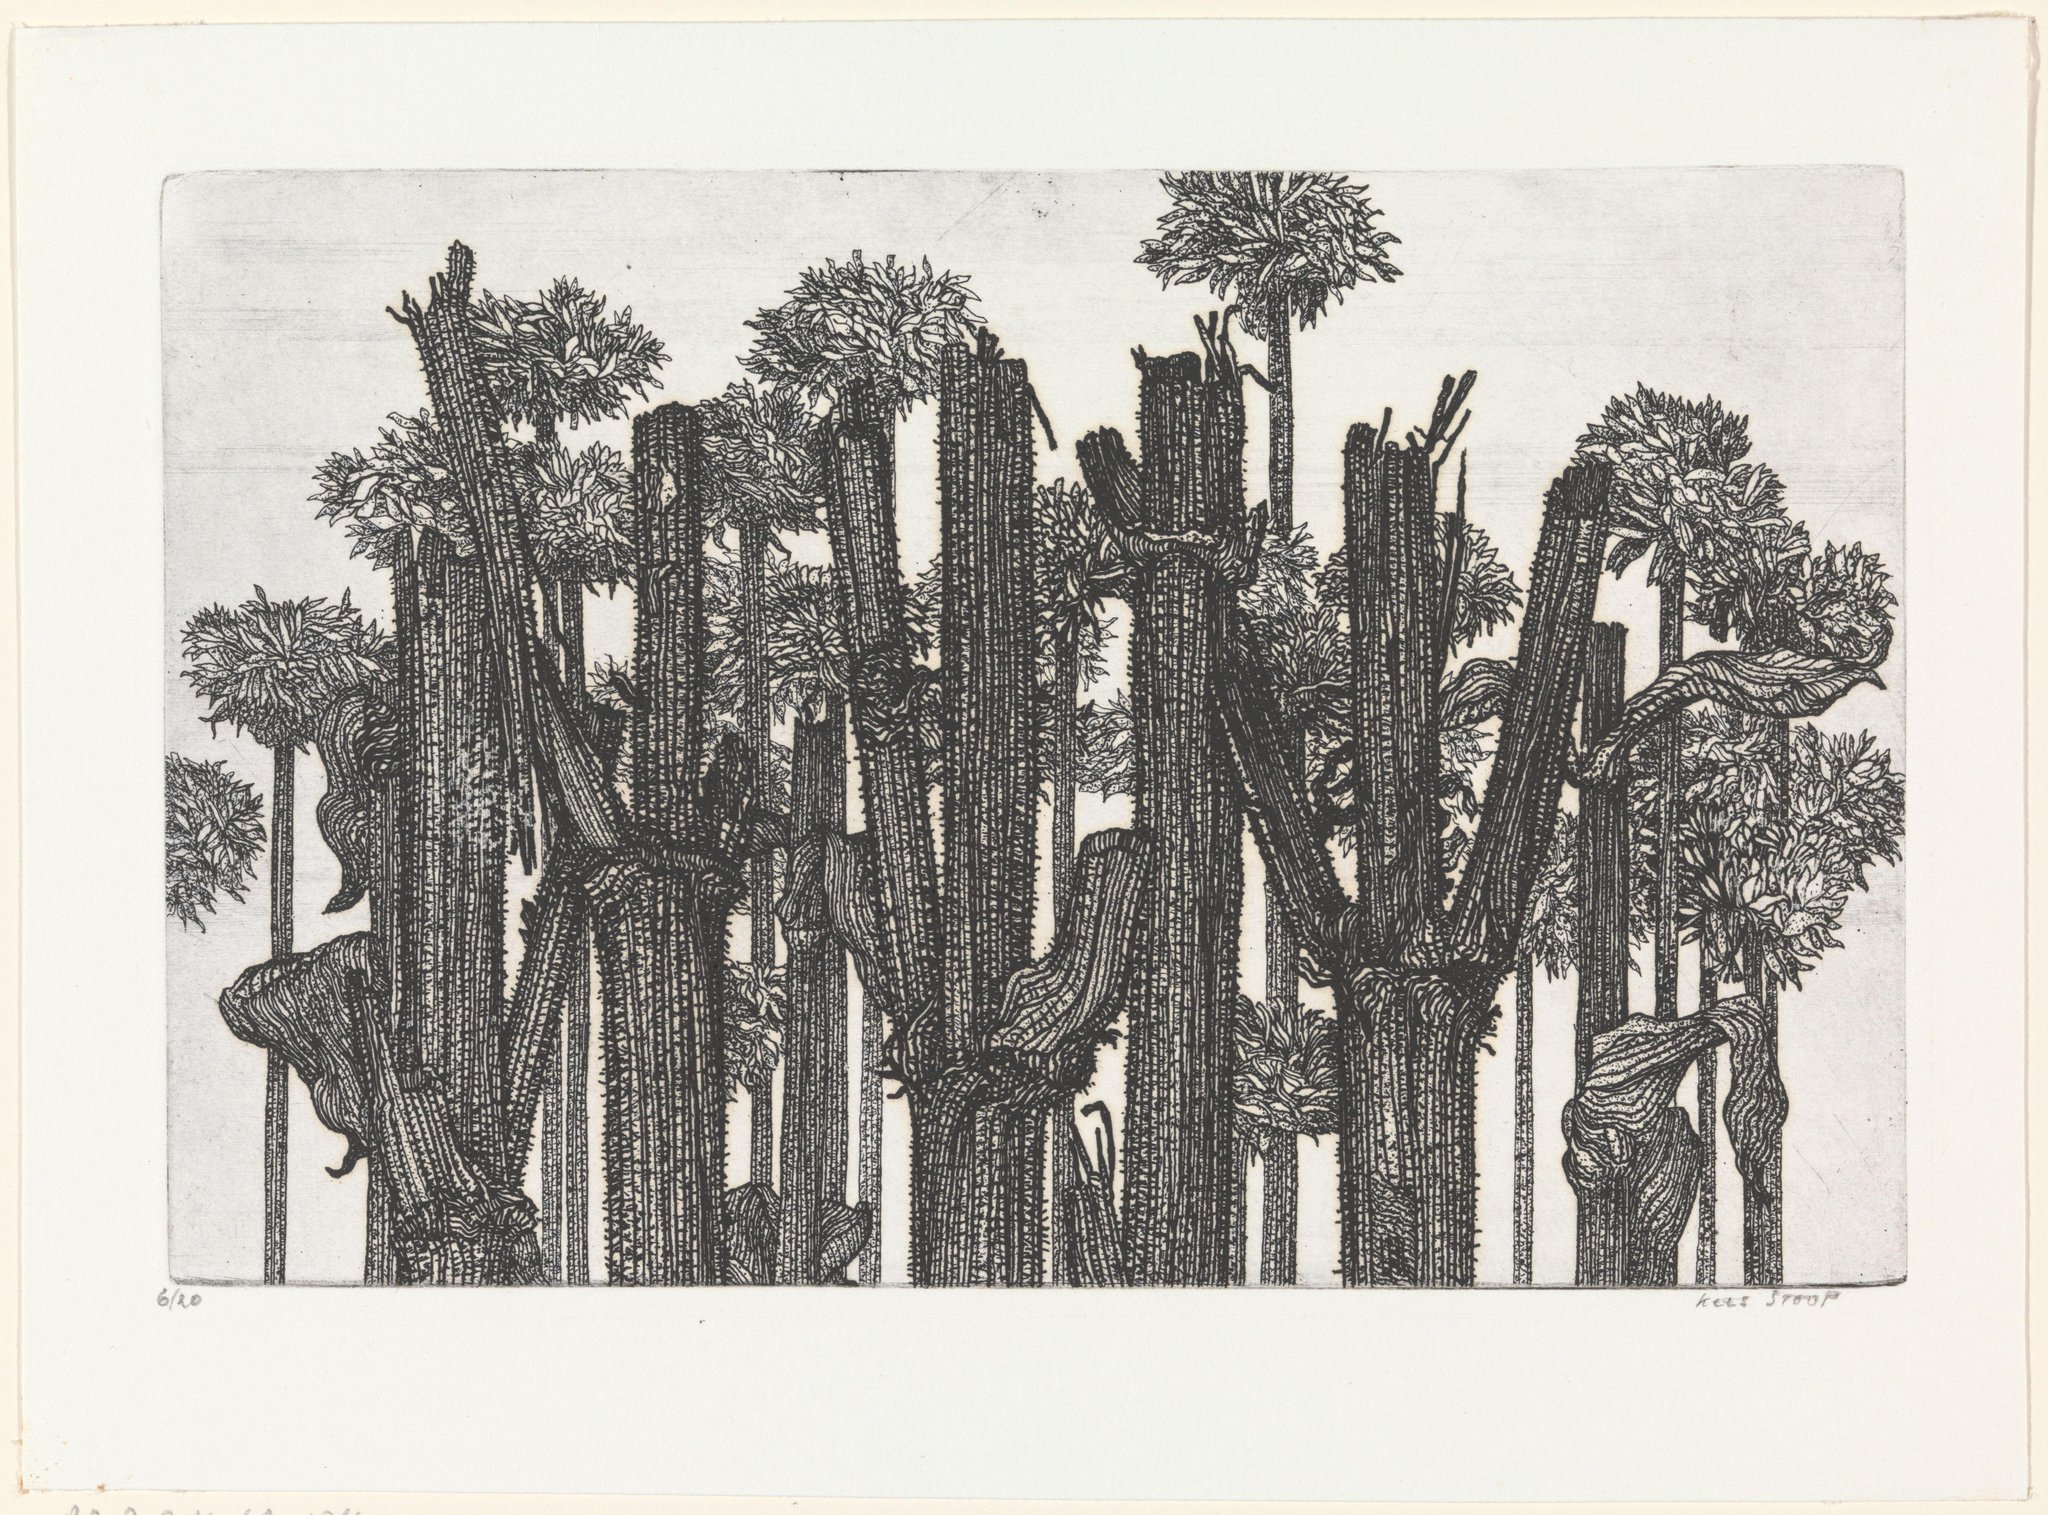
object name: print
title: Vertakte stengels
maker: kees stoop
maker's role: draughtsman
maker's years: 1929-2019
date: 1970-1972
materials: paper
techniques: etching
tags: plants and herbs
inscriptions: edition: ‘6/20’, signature: ‘KEES STOOP’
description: Vertakte stengels met verticale lijnen met afgebroken toppen, op de achtergrond bloemen.